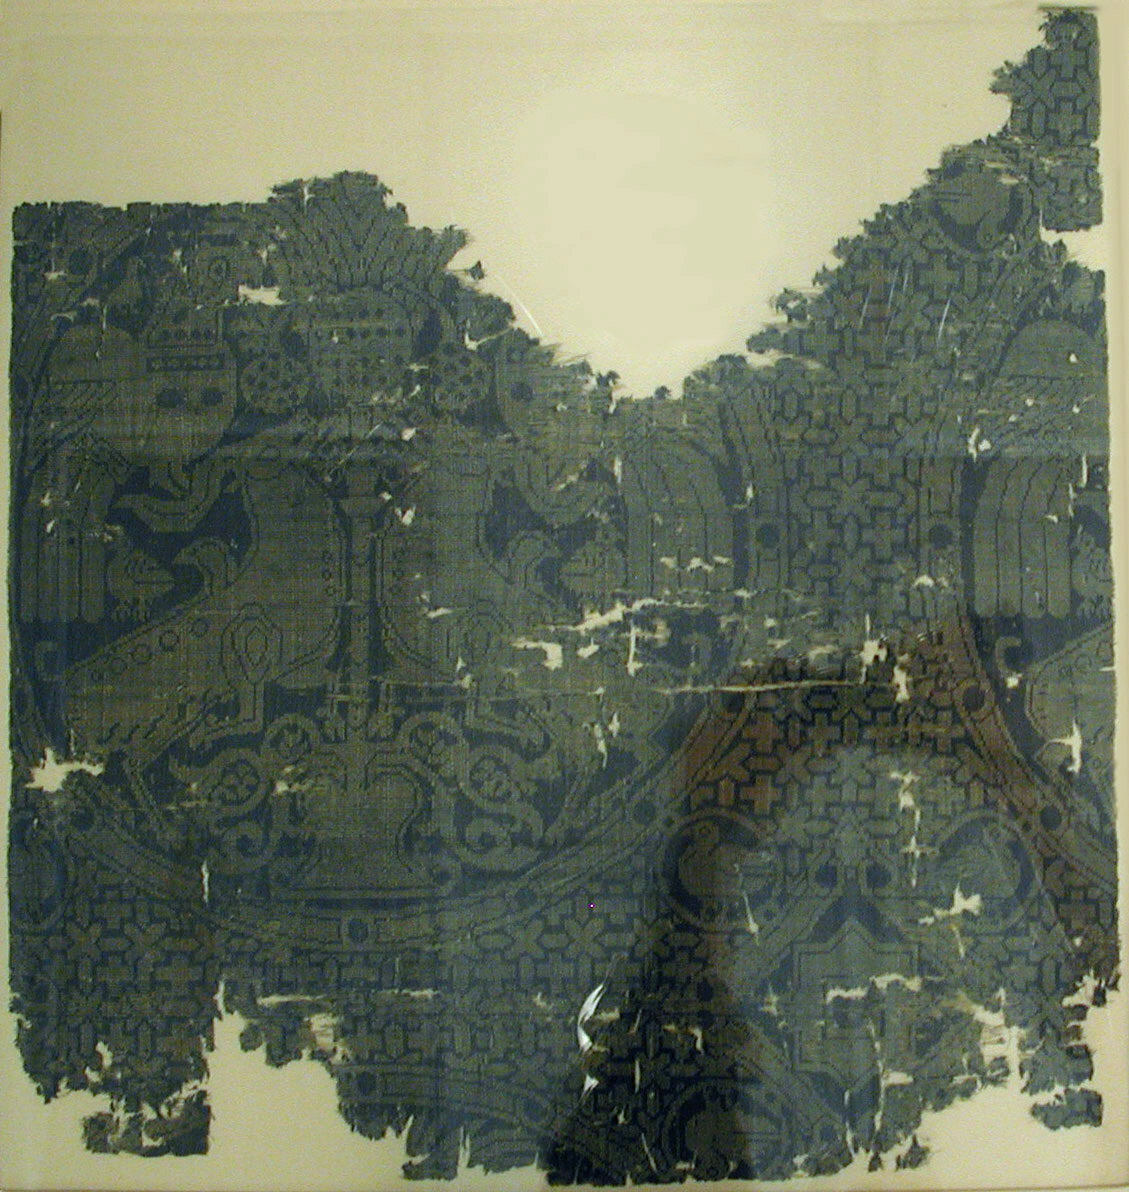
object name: textile fragment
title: Textile with Birds and Horned Quadrupeds Flanking a Tree of Life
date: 1001-1200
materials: silk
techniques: weave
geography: iran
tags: birds